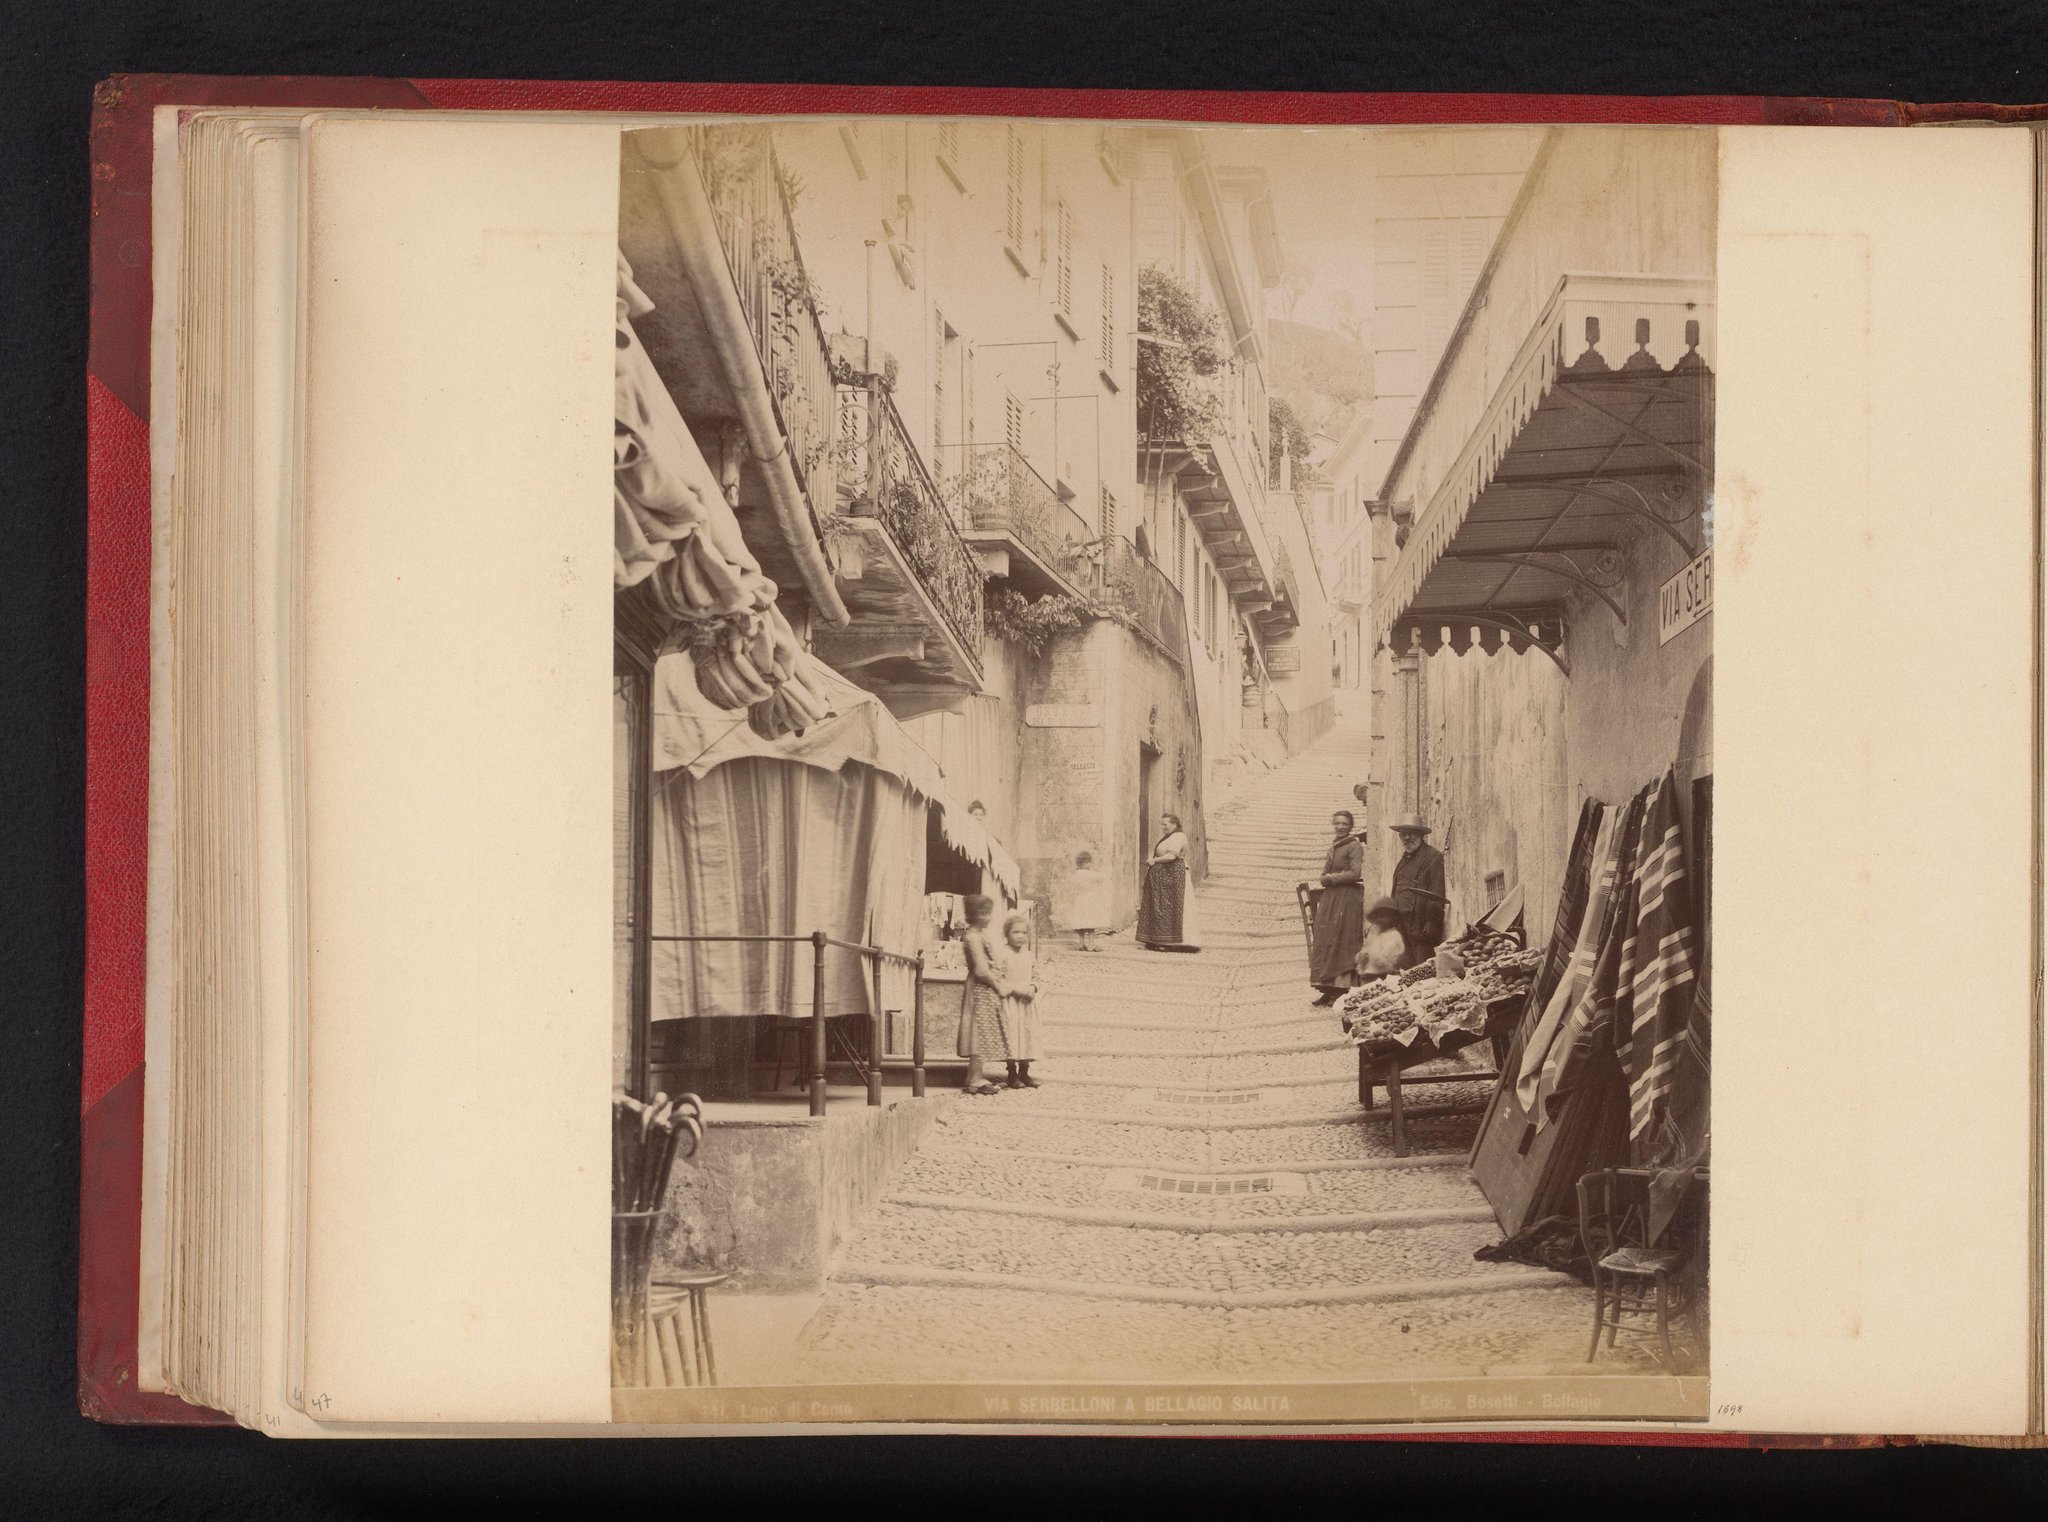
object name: photograph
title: Gezicht op de Via Serbelloni te Bellagio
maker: bosetti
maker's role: publisher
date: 1898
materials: photographic support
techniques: albumen print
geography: bellagio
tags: street (+ city(-scape) with figures, staffage)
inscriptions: annotation: ‘1898’, inscription: ‘141. Lago di Como/ Via Serbelloni a Bellagio Salita/ Ediz. Bosetti - Bellagio’